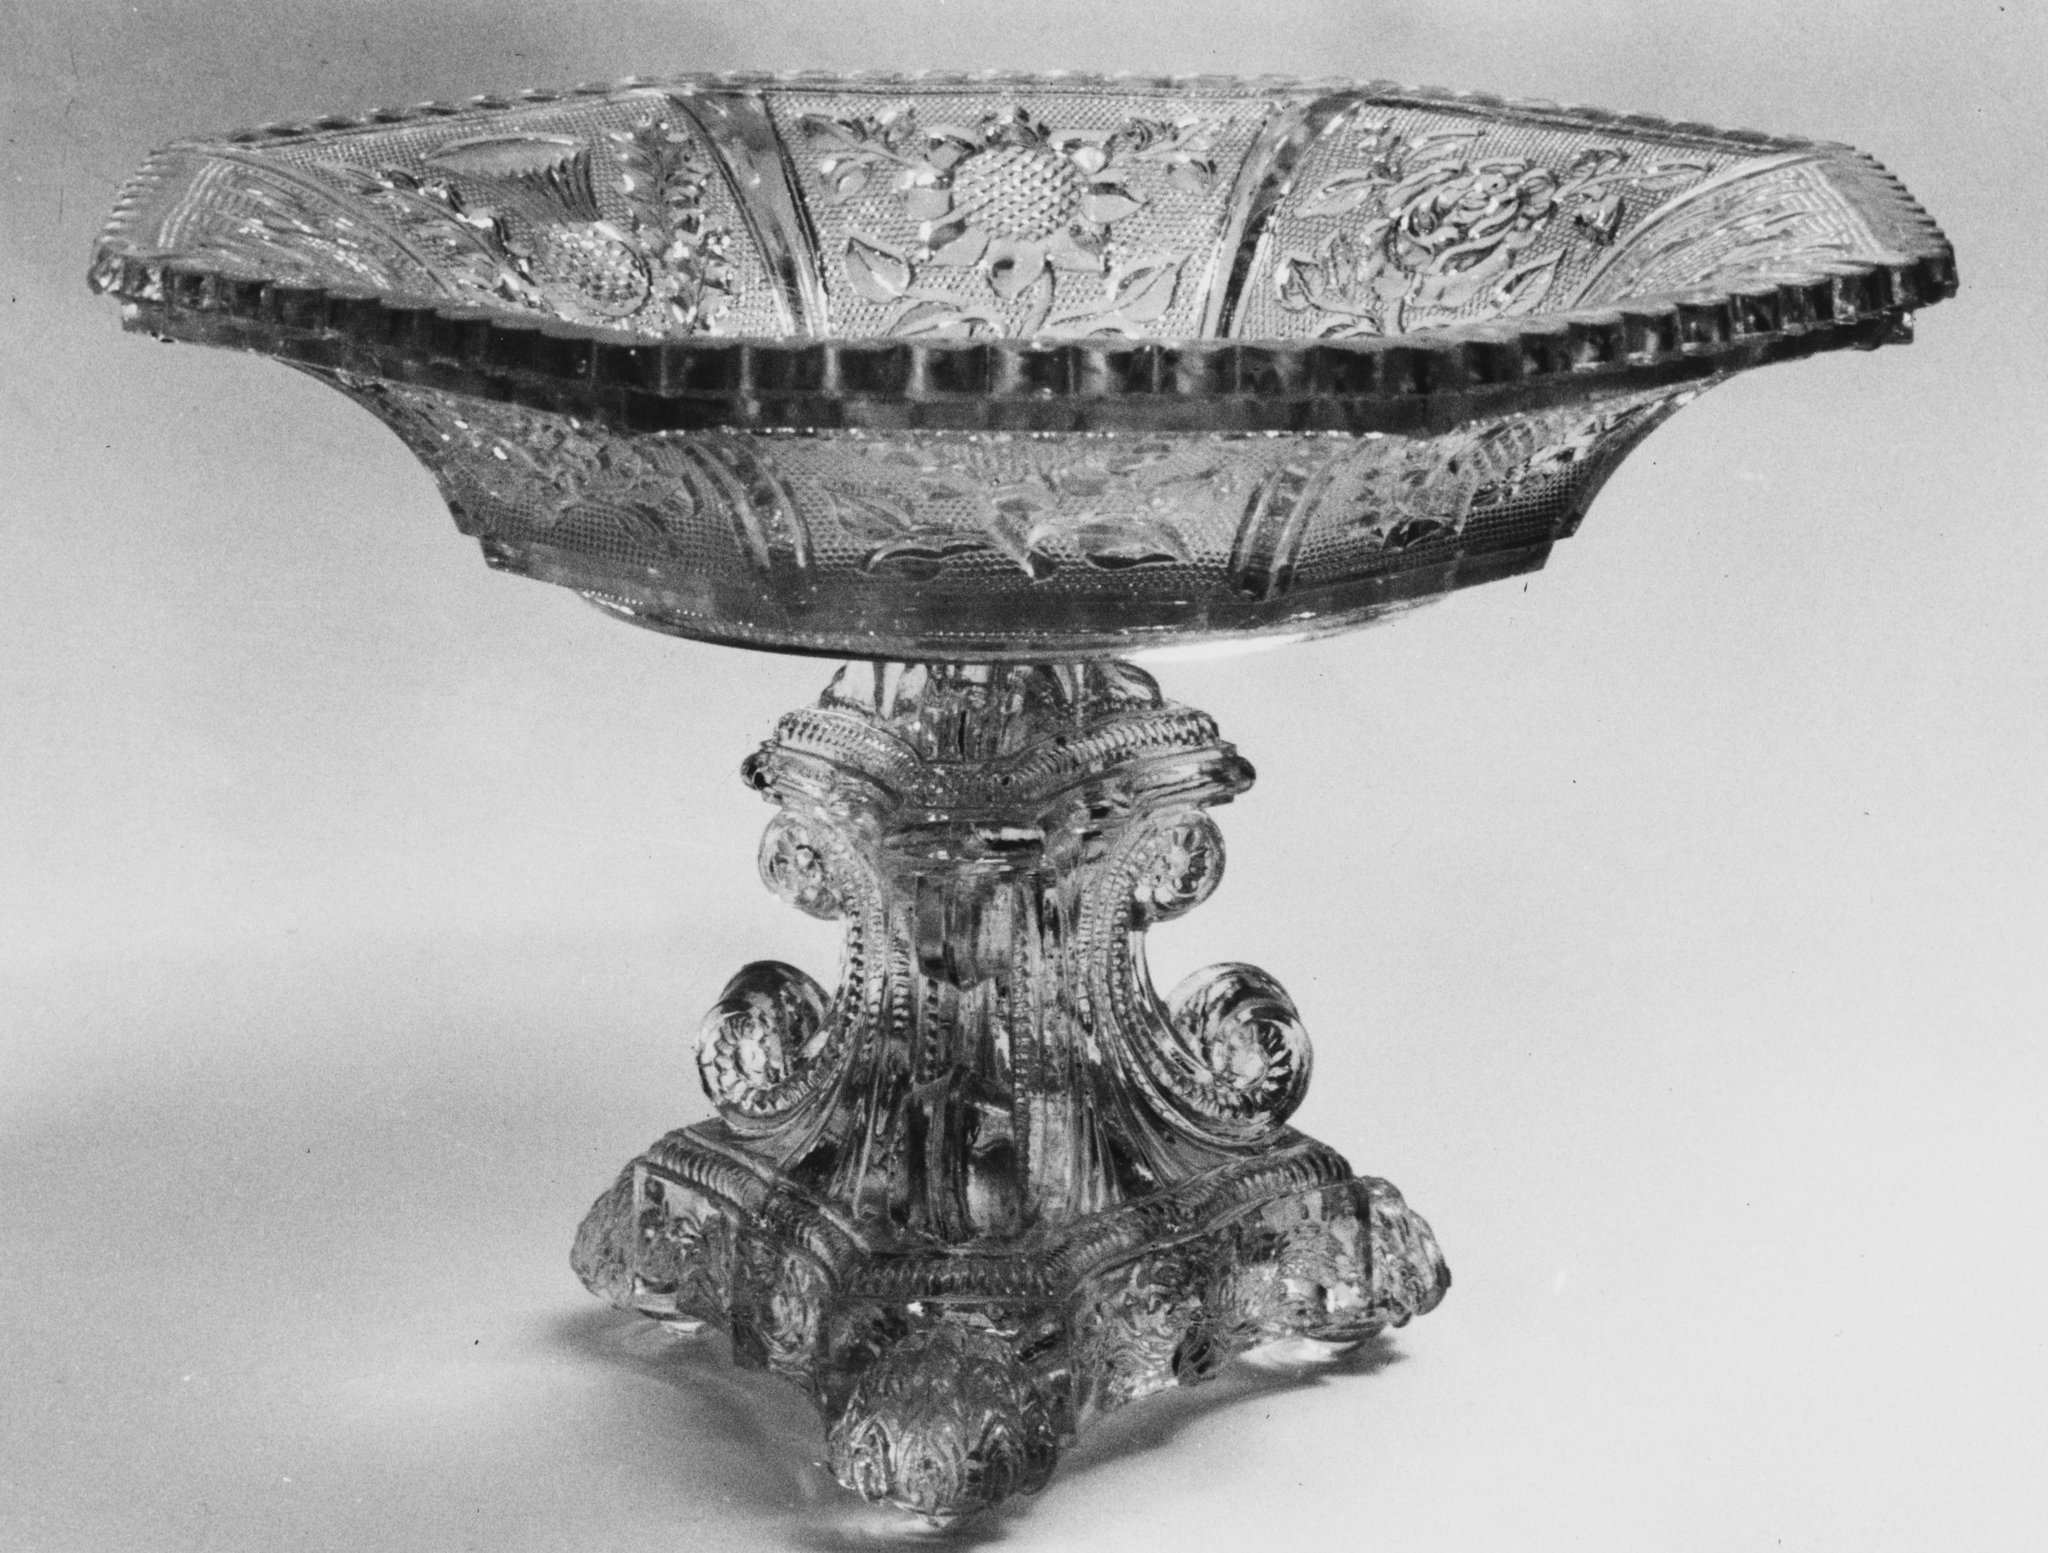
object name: compote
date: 1801-1900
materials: glass